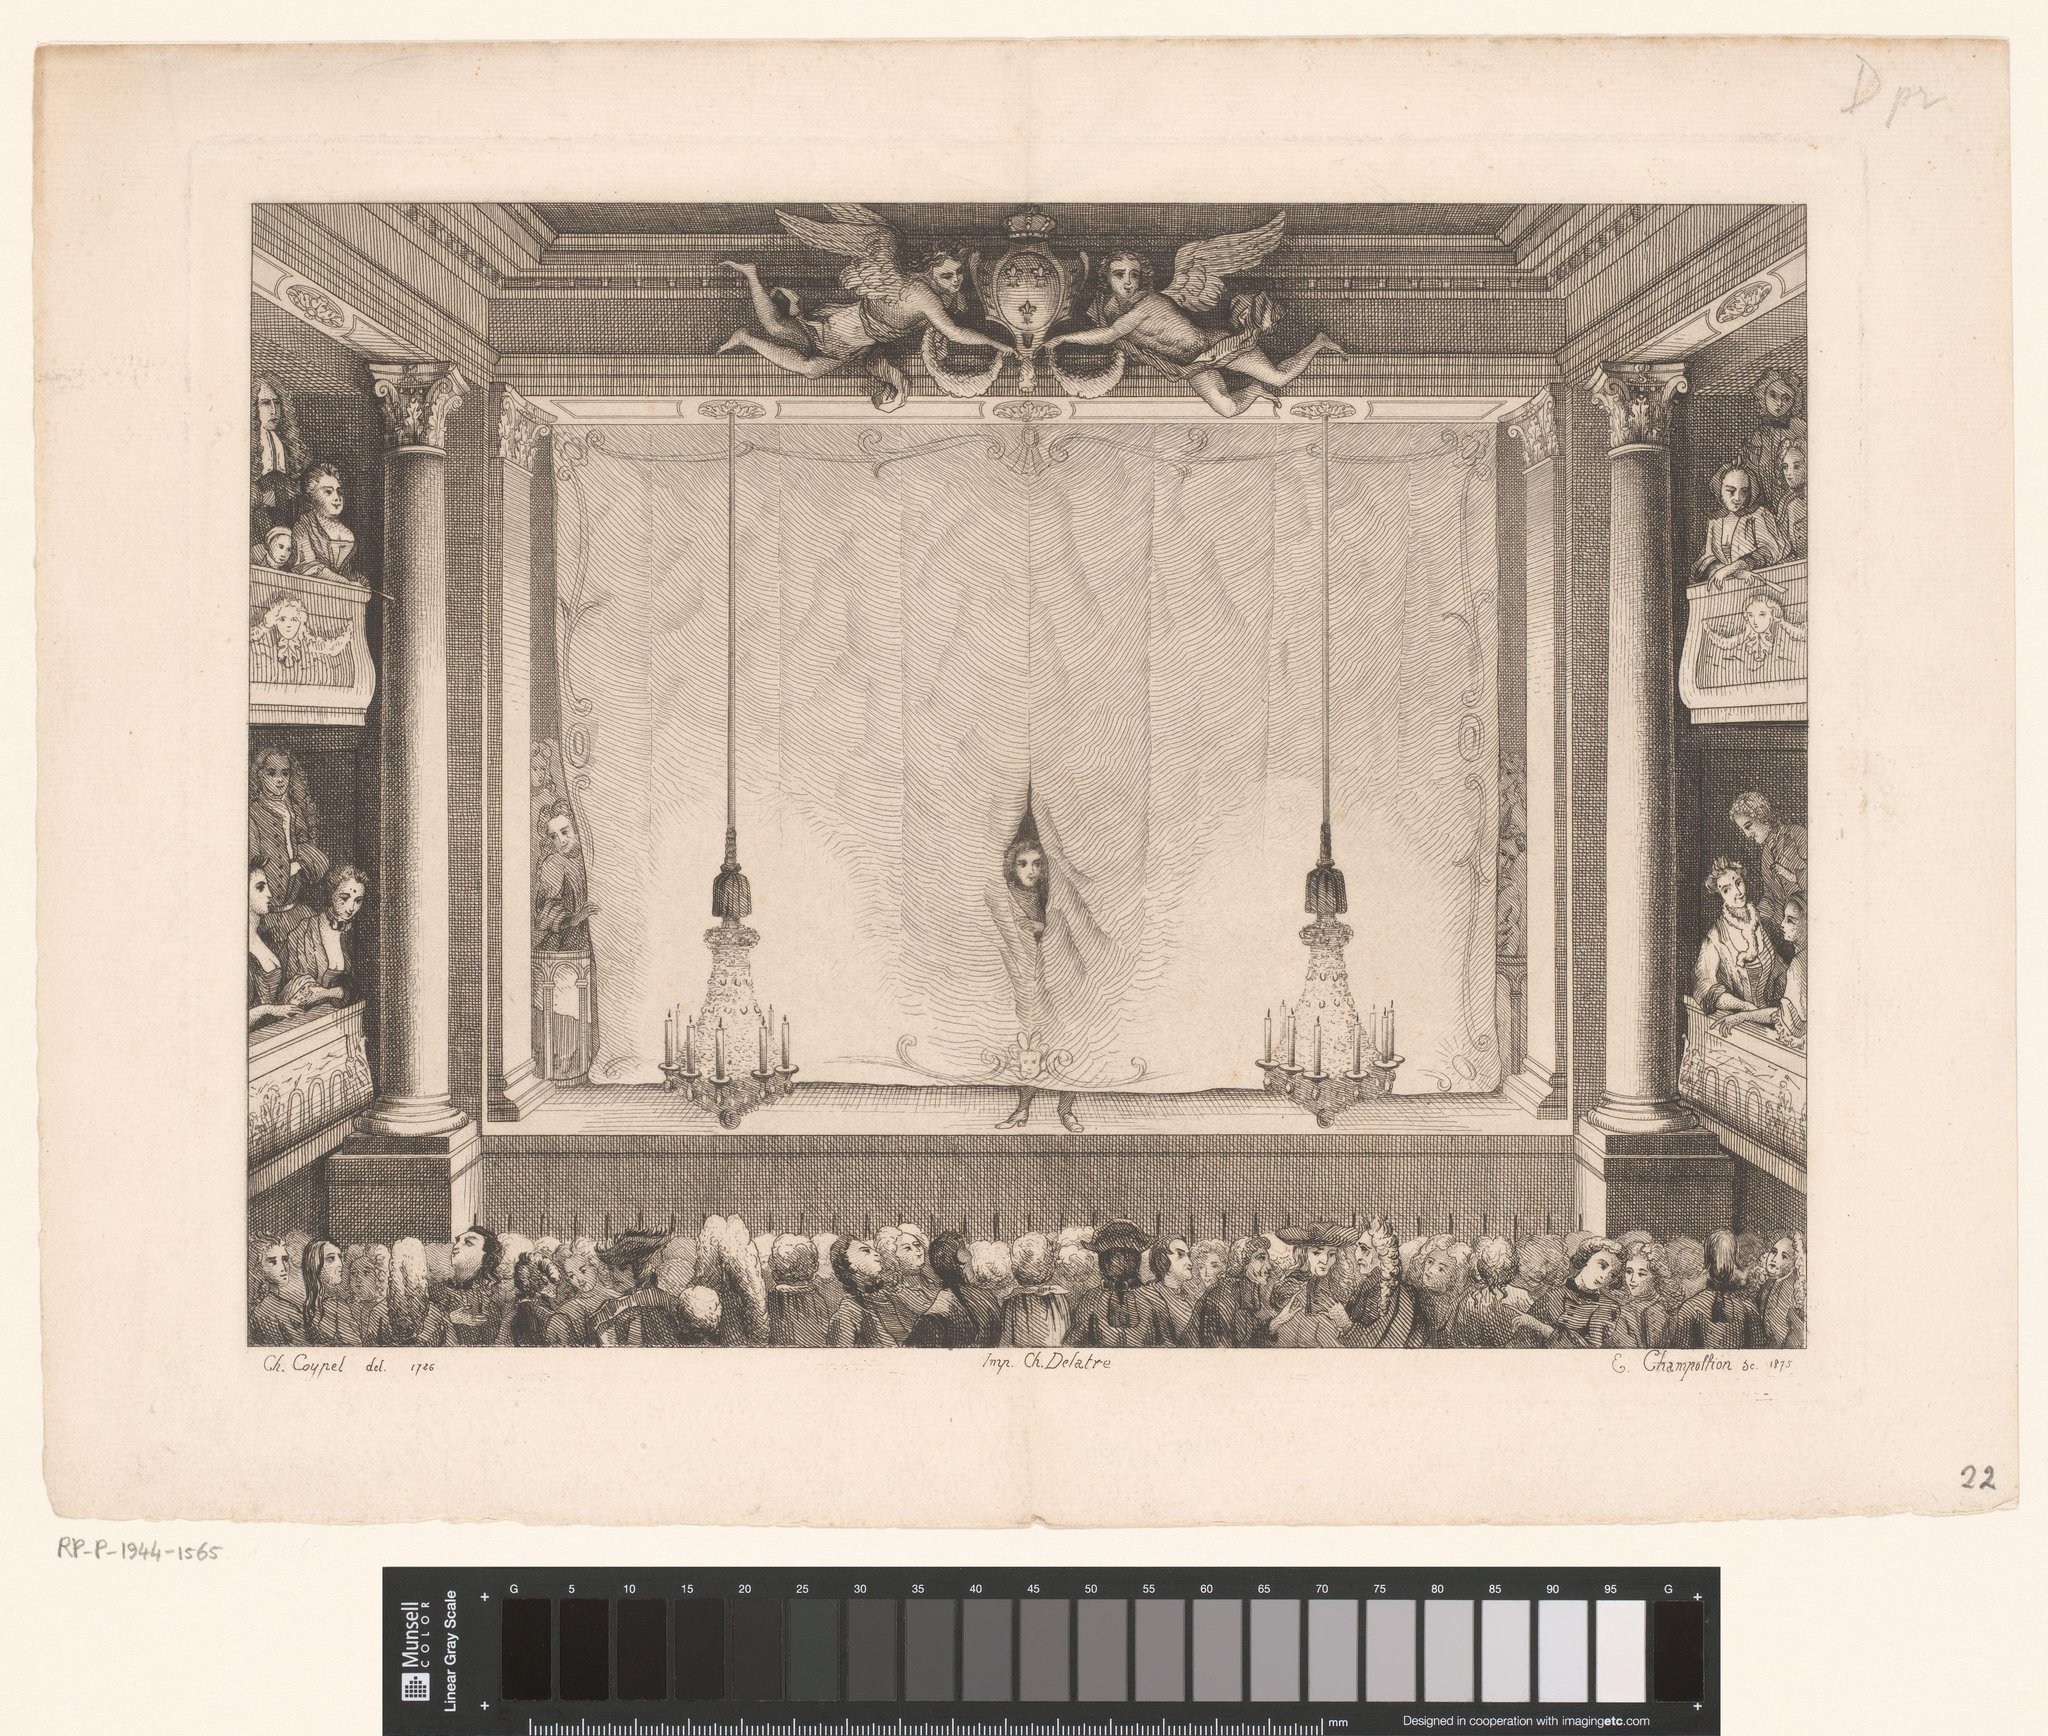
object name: print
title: Theater met neergelaten gordijn waar doorheen een acteur de zaal inkijkt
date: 1875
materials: paper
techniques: engraving, etching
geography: france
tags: theatre (building), the audience ~ art performance, the stage and its equipment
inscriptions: collector's mark: Lugt 2228